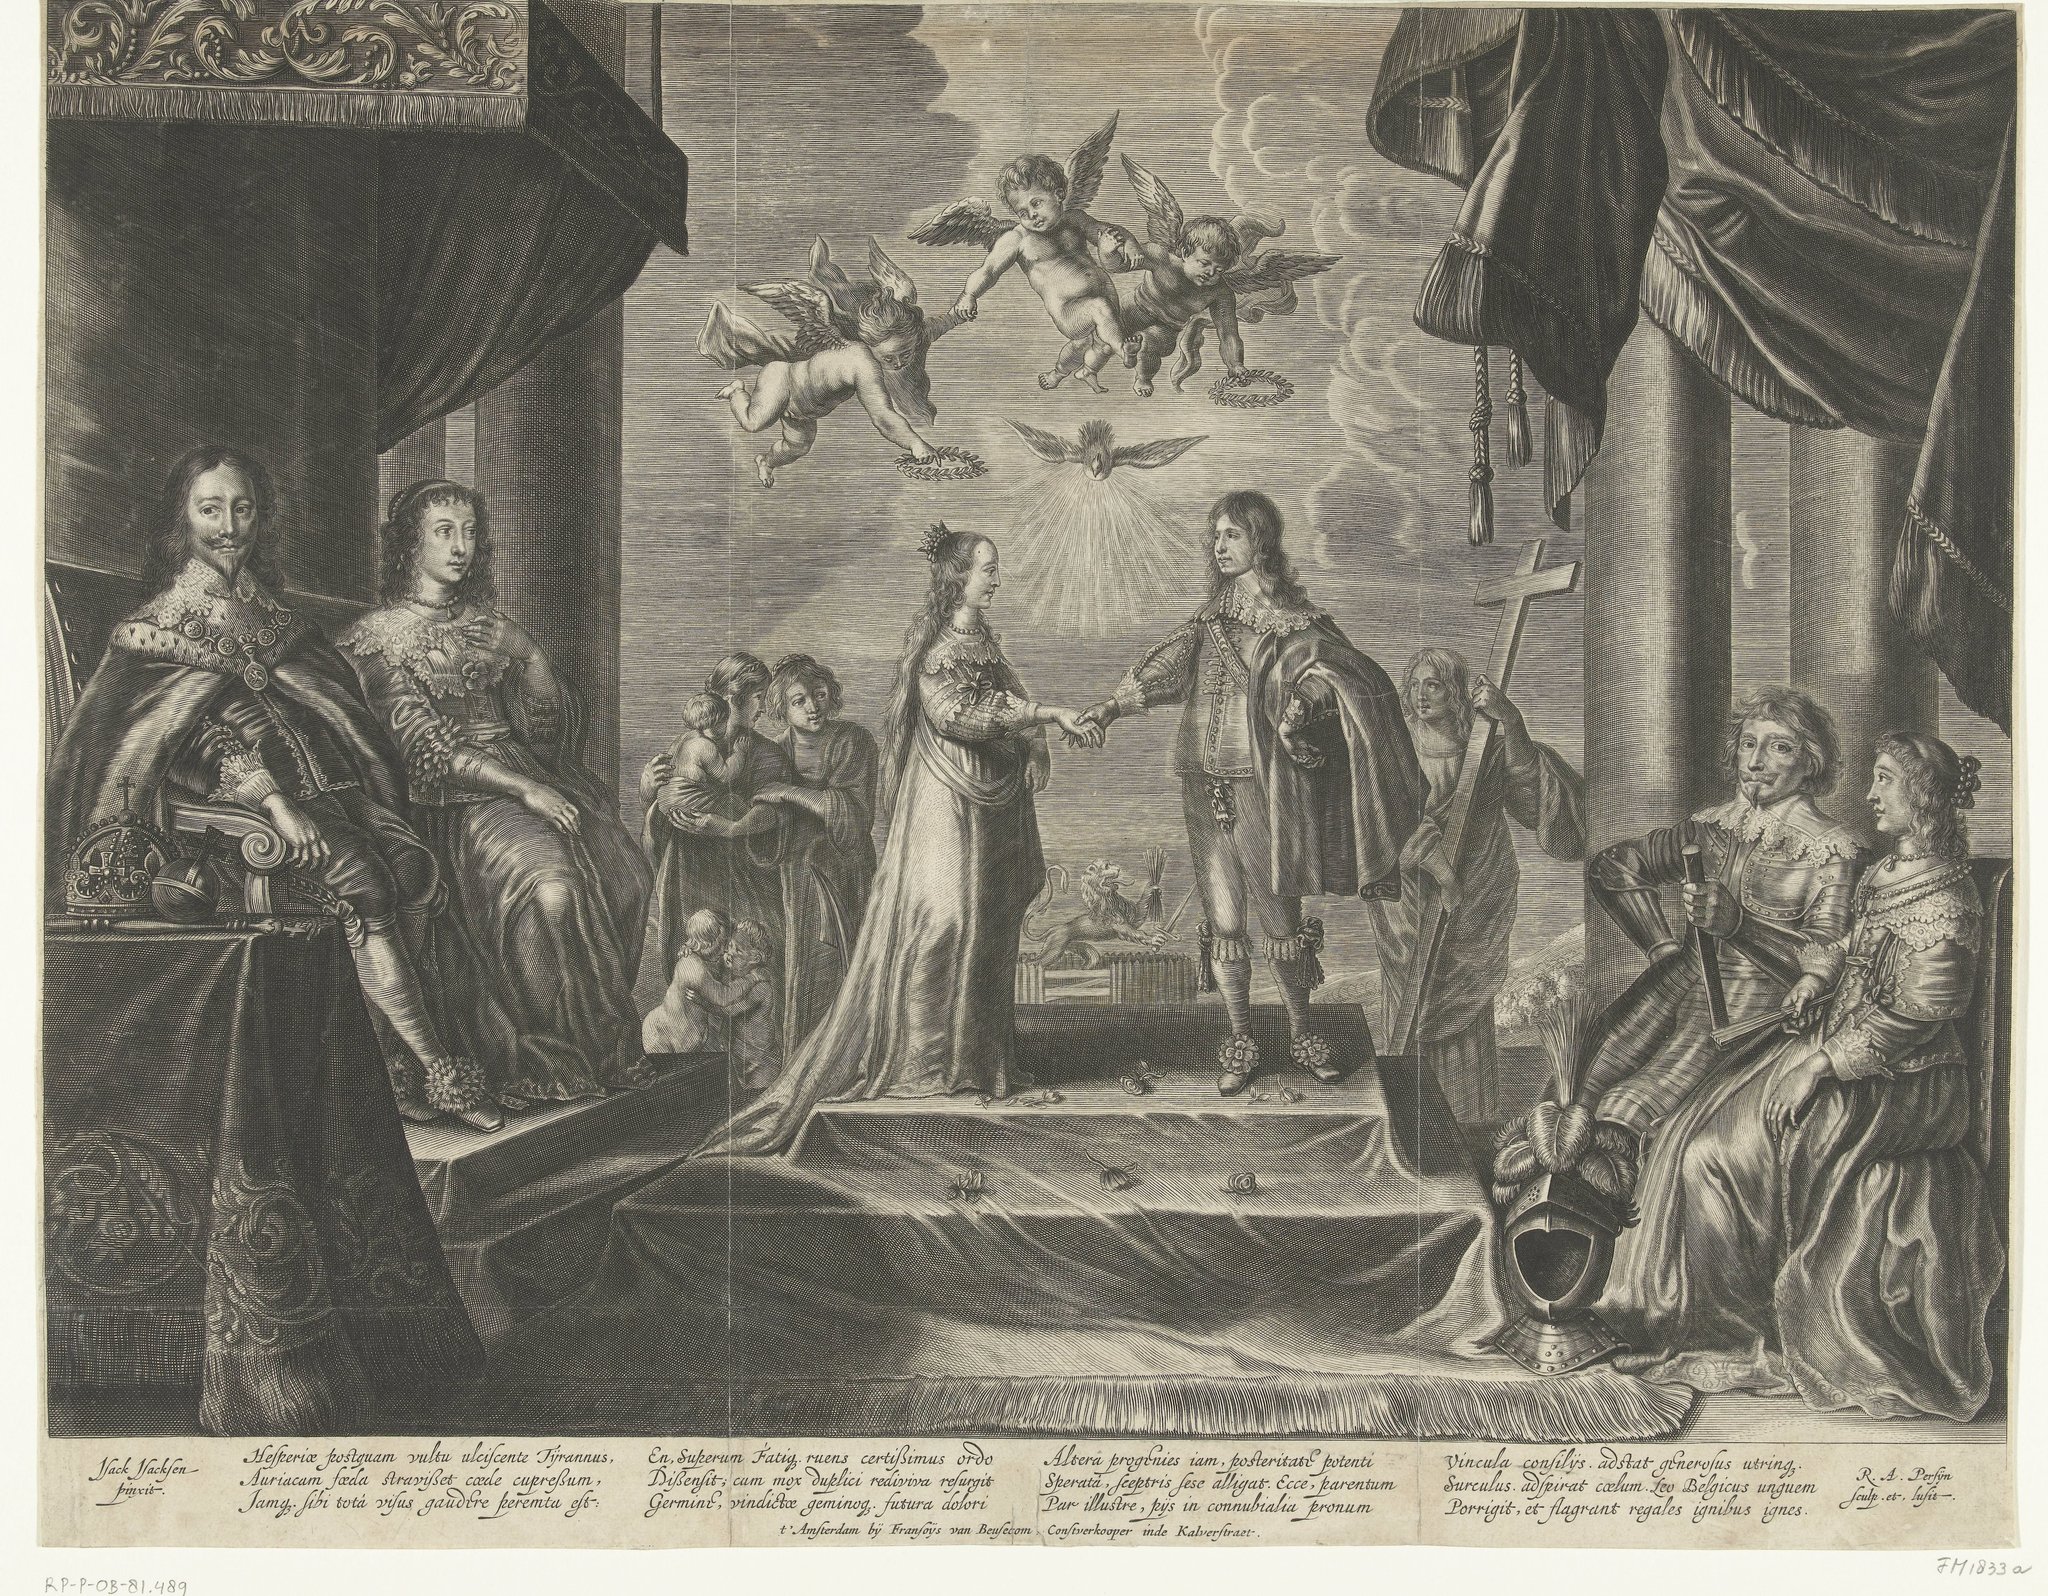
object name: print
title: Huwelijk van prins Willem II en Maria Stuart, 1641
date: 1641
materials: paper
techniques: engraving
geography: northern netherlands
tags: henriëtta maria van frankrijk (koningin van engeland, schotland en ierland), delft, frederick henry (prince of orange), william ii (prince of orange), the hague, amalia of solms-braunfels, mary henrietta stuart, london, karel i (koning van engeland), marriage, married couple, 'matrimonium'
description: Het huwelijk van prins Willem II en prinses Maria Stuart, 2 mei 1641. Links de ouders van de bruid: de Engelse koning Karel I en zijn vrouw Henrietta Maria. Rechts de ouders van de bruidegom: Frederik Hendrik en Amalia van Solms. Op de achtergrond allegorische figuren van Liefde en Hoop en Rechtvaardigheid en de Hollandse Leeuw in de Hollandse Tuin. Boven het paar de duif van de Heilige Geest en putti met lauwerkransen. Onder de voorstelling 4 verzen van 4 regels in het Latijn.